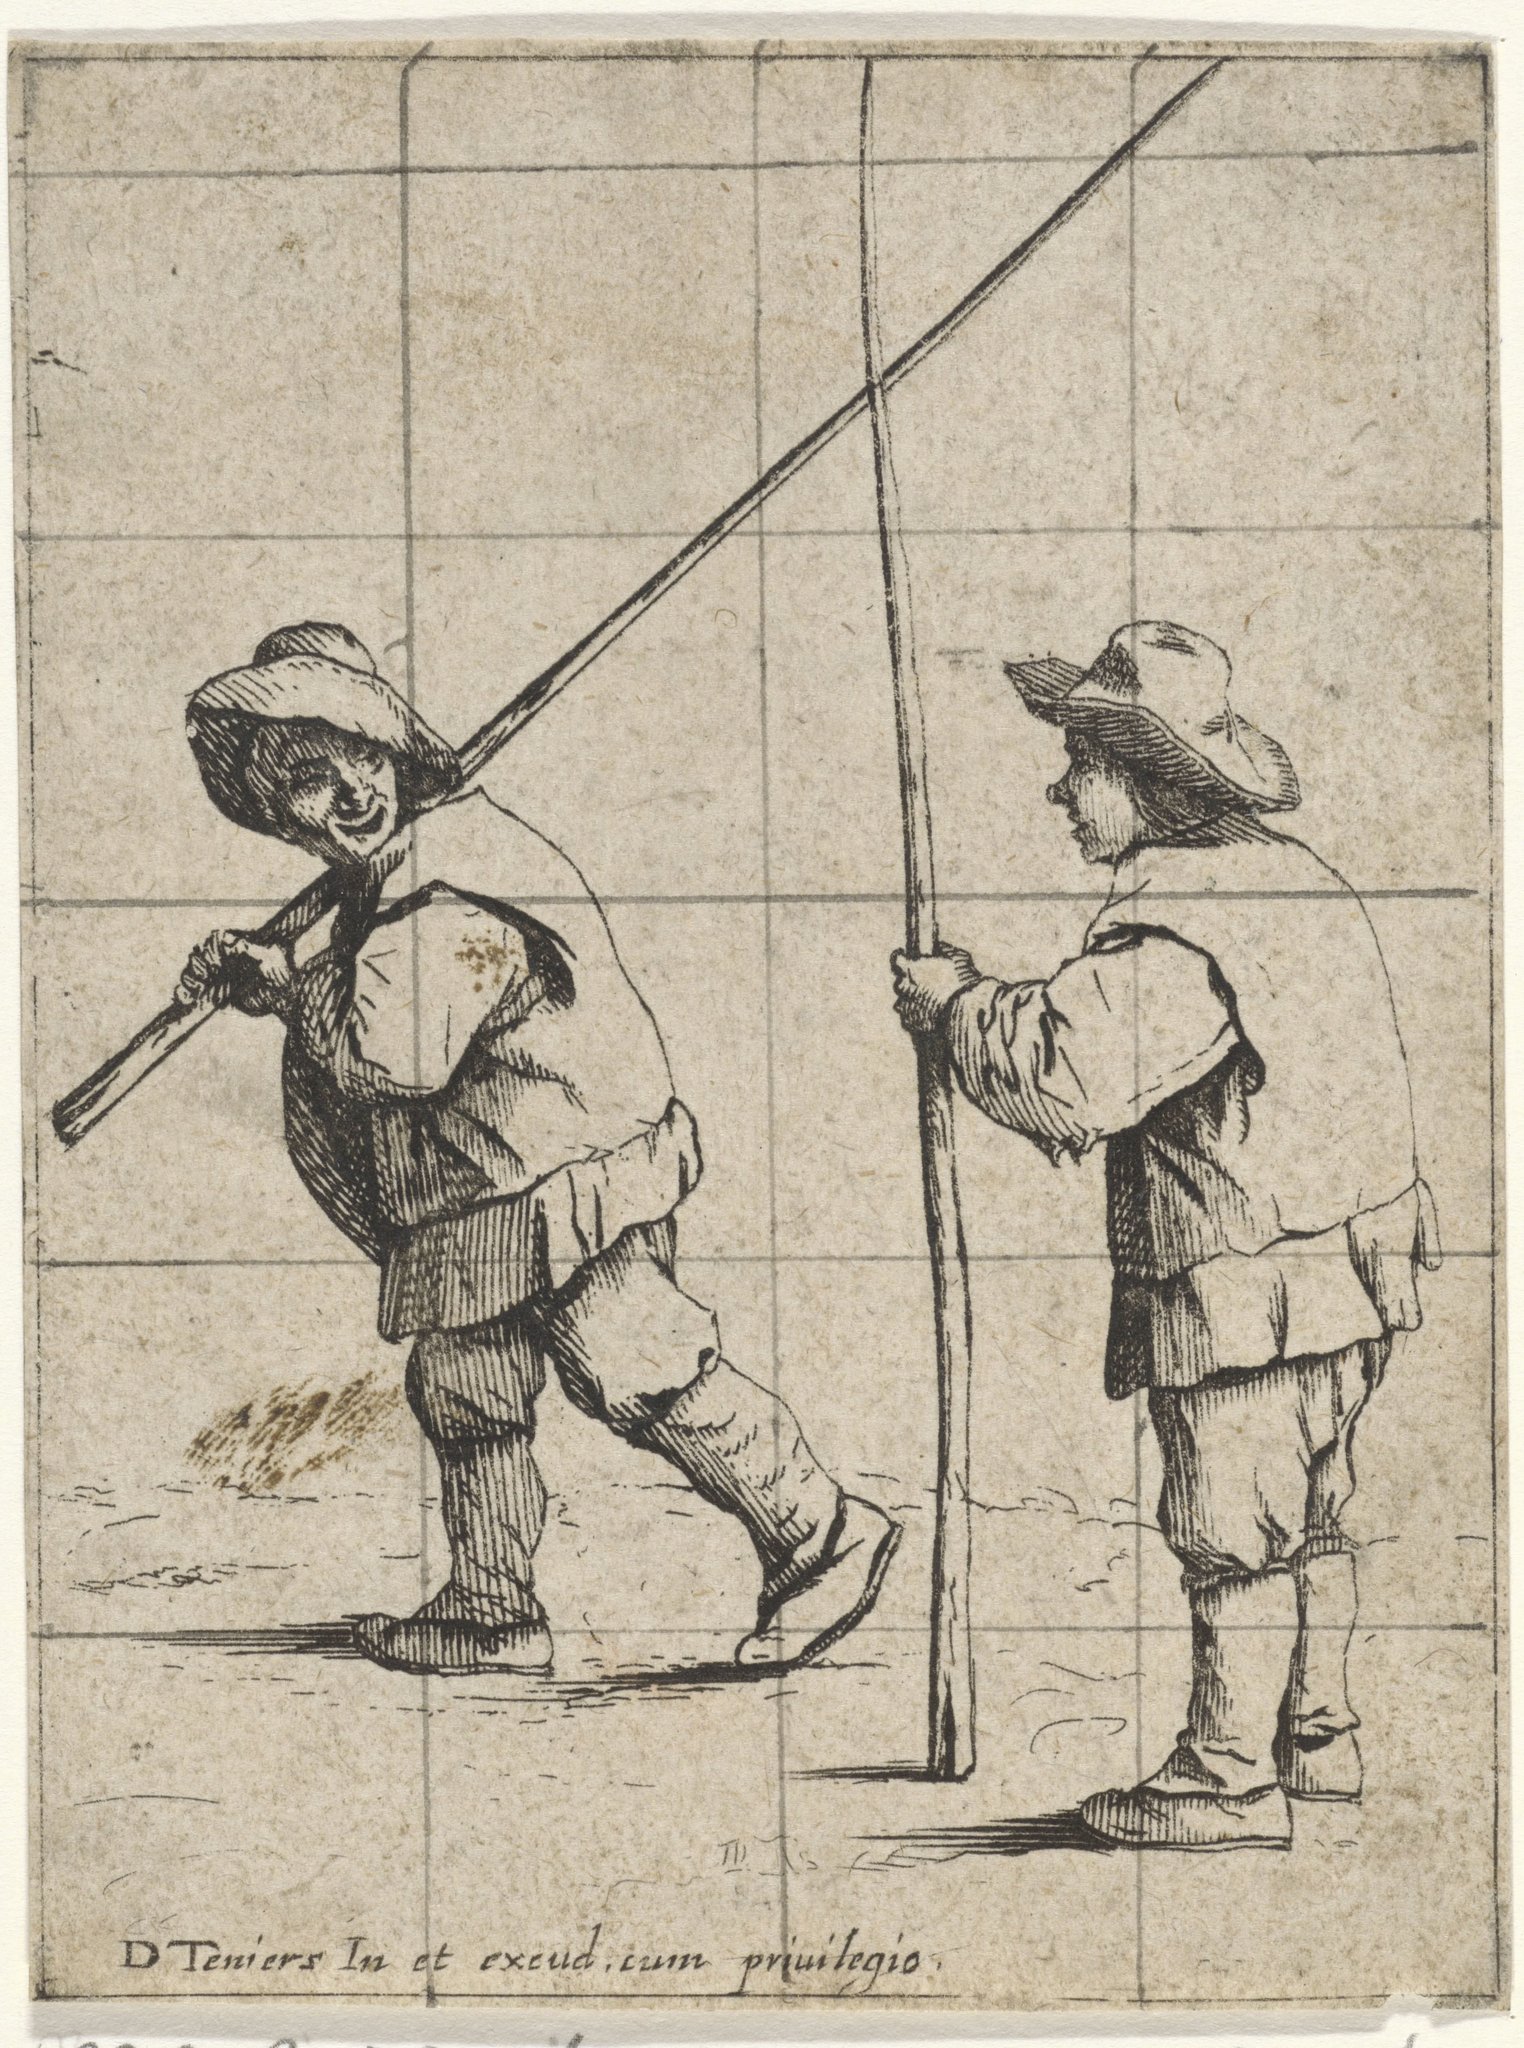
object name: print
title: Boeren ten voeten uit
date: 1630-1668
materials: paper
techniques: etching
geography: brussels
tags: ditch-over with jumping pole (jumping game), walking-stick, staff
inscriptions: collector's mark: Lugt 2228